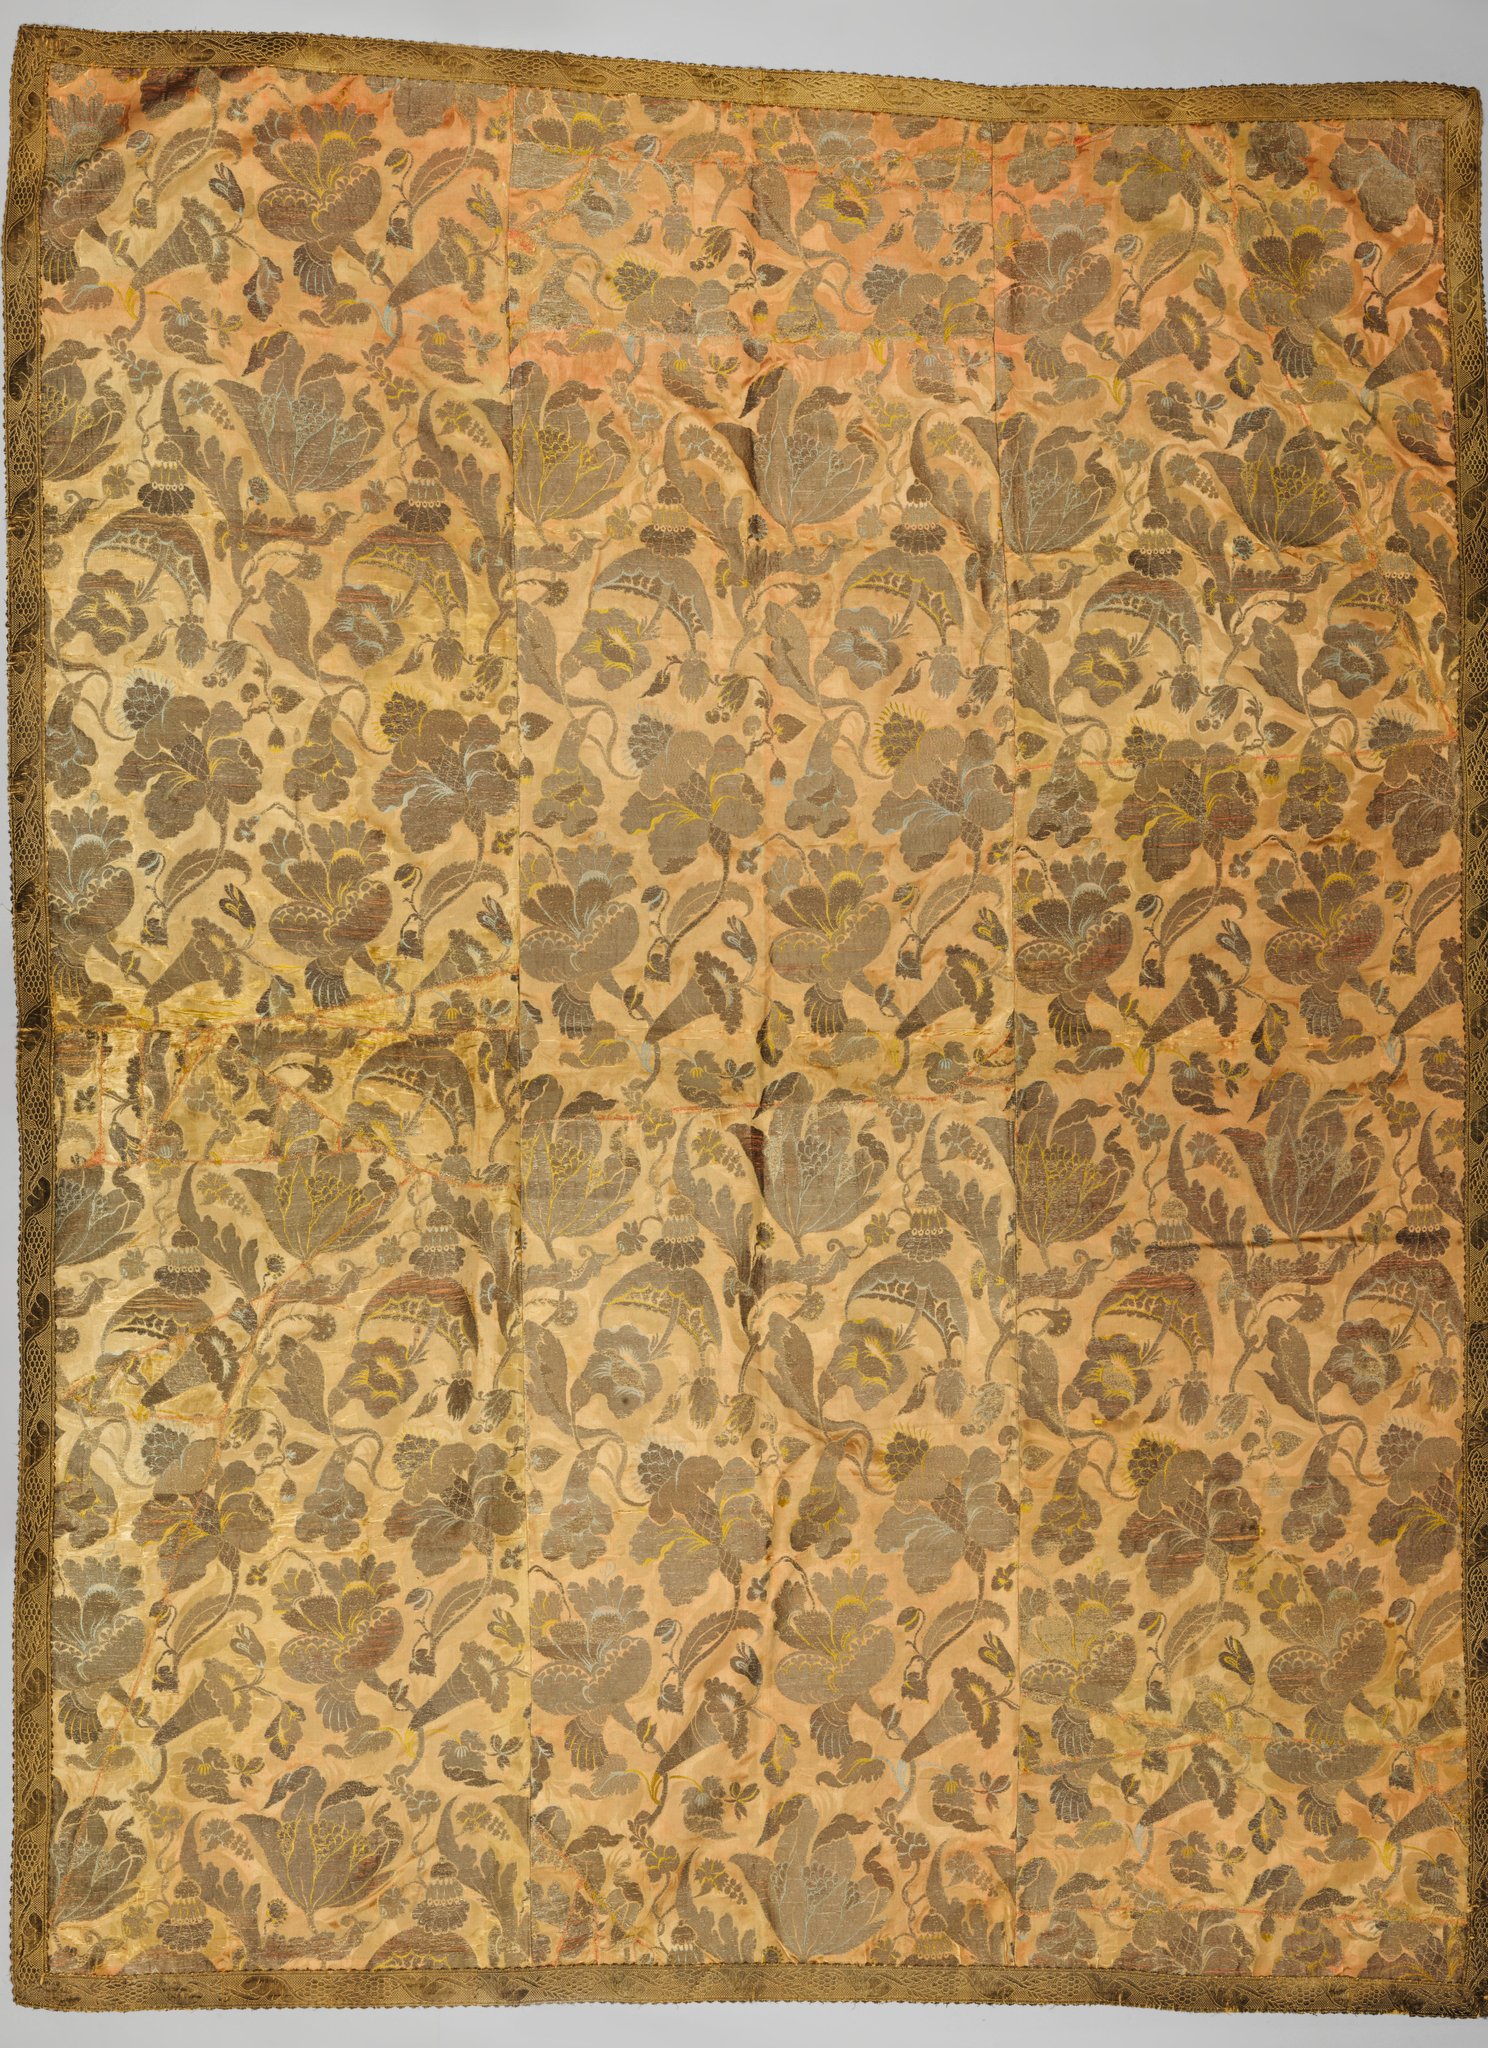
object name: kleed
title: Kleed van zijde, samengesteld uit drie banen die weer opgebouwd zijn uit twintig fragmenten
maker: Anonymous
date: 1730-1740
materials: silk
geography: france